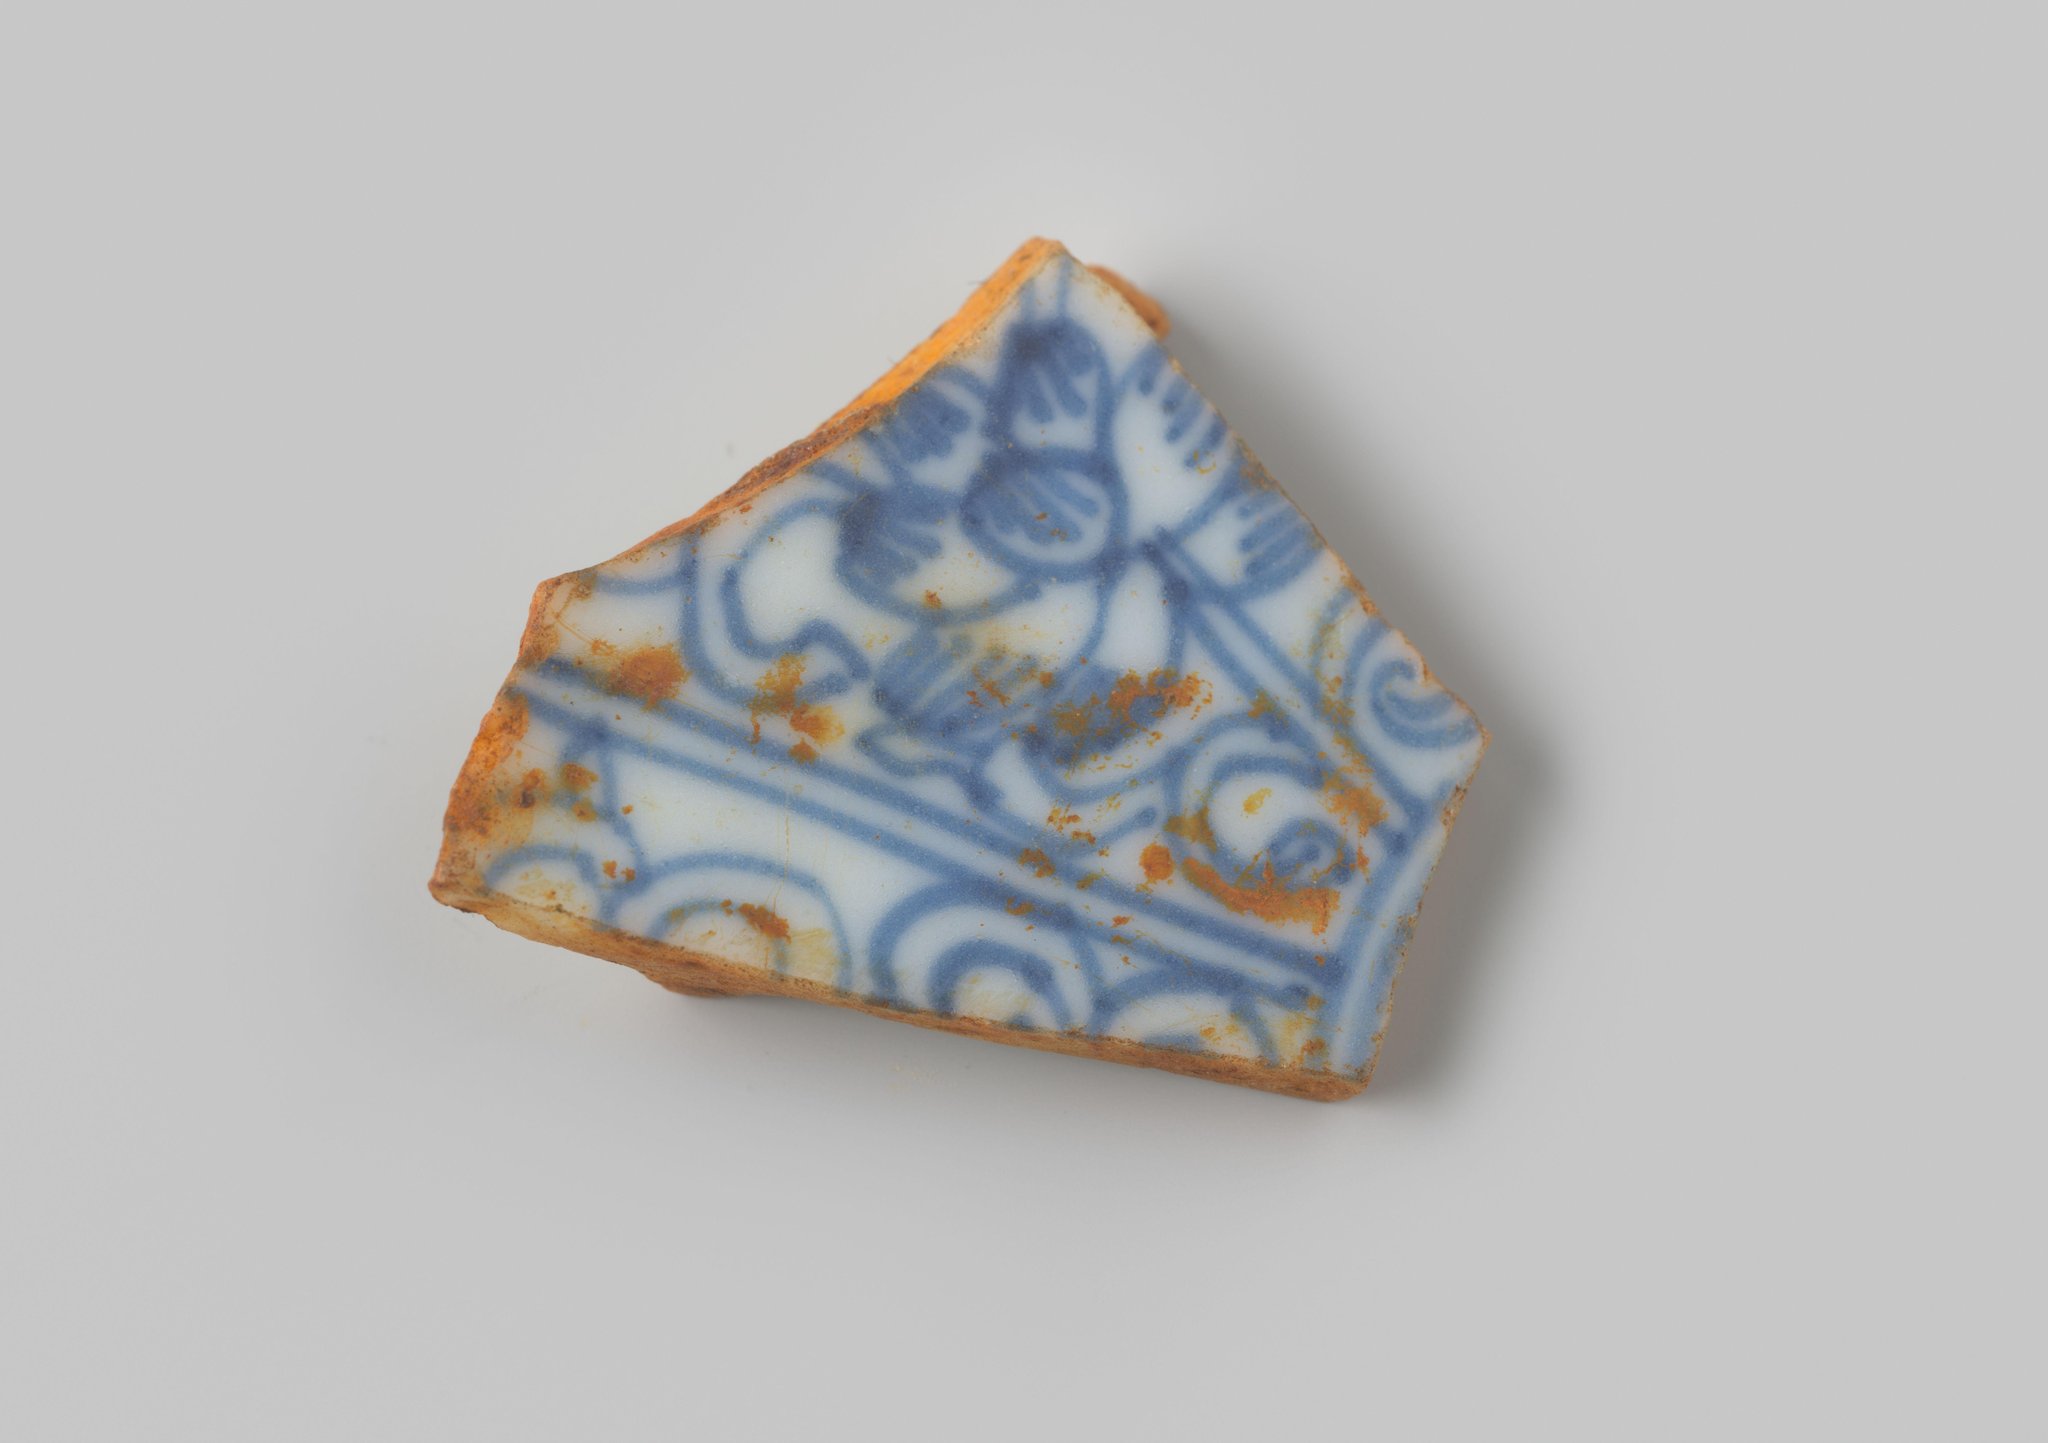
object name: sherd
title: Scherf van een schotel uit het wrak van de Oost-Indiëvaarder Hollandia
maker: Anonymous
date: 1700-1743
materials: porcelain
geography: netherlands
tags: verenigde oostindische compagnie, hollandia (schip), annet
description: Porcelain, dish, fragment; fragm, flat, decorated.